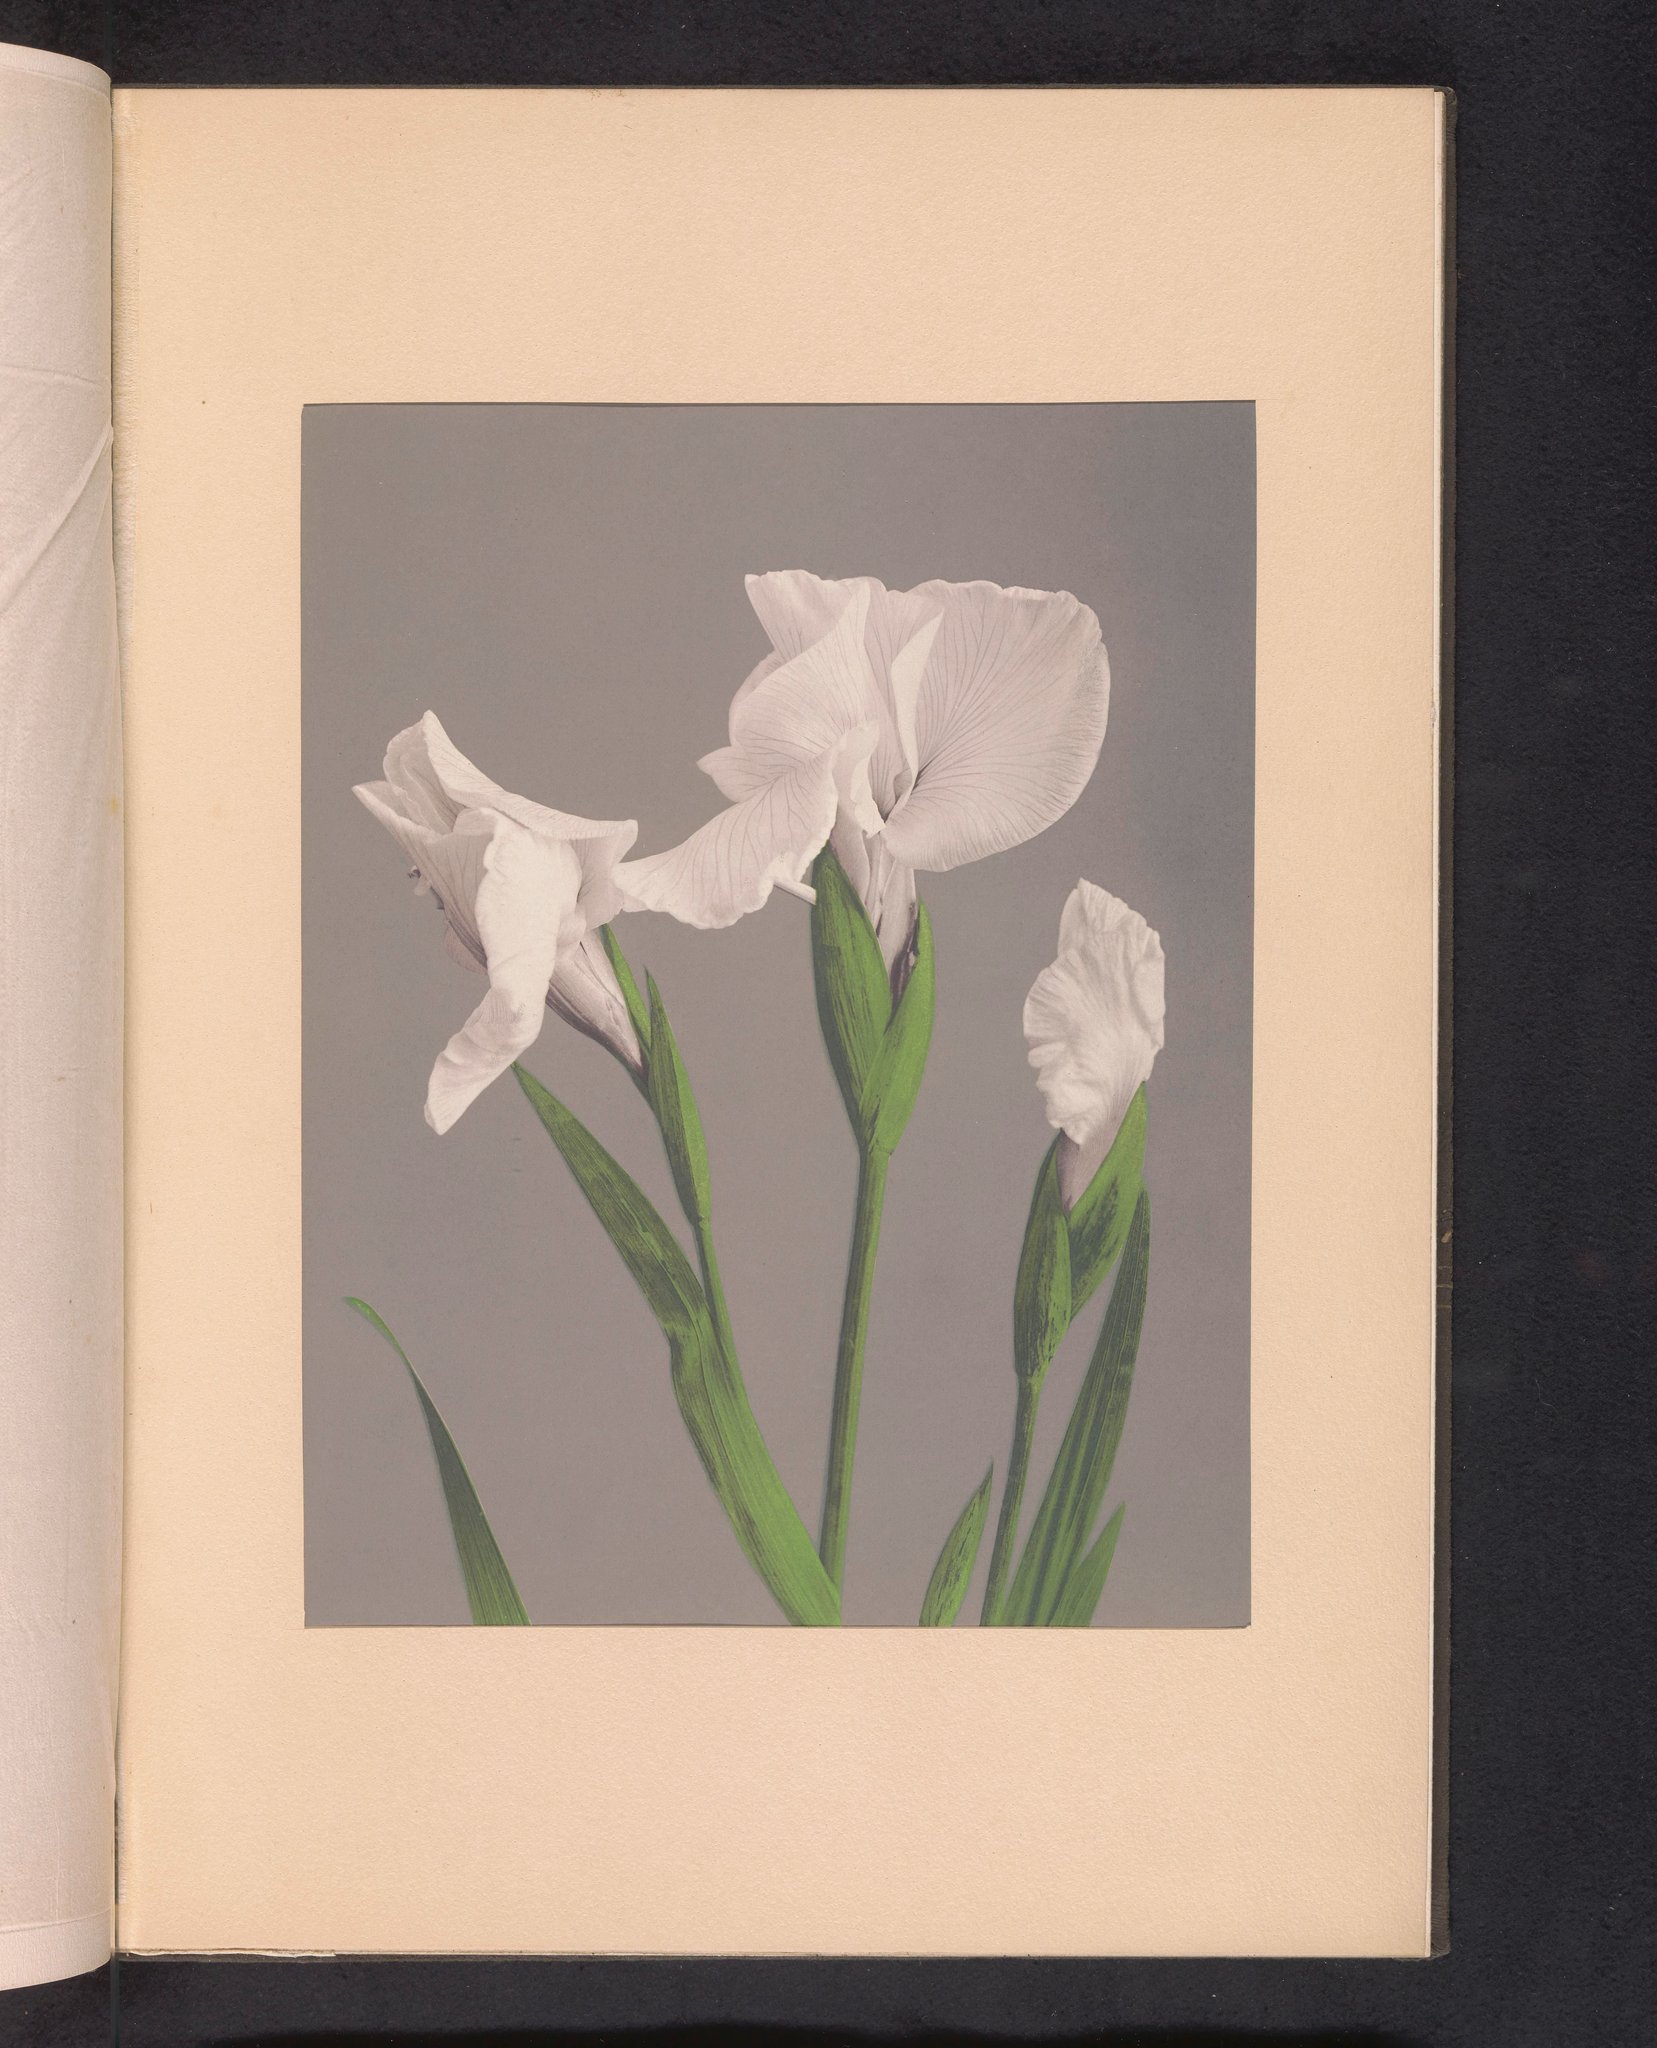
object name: photomechanical print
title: Witte irissen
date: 1887-1897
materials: paper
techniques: photograph, hand coloring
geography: japan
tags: flowers